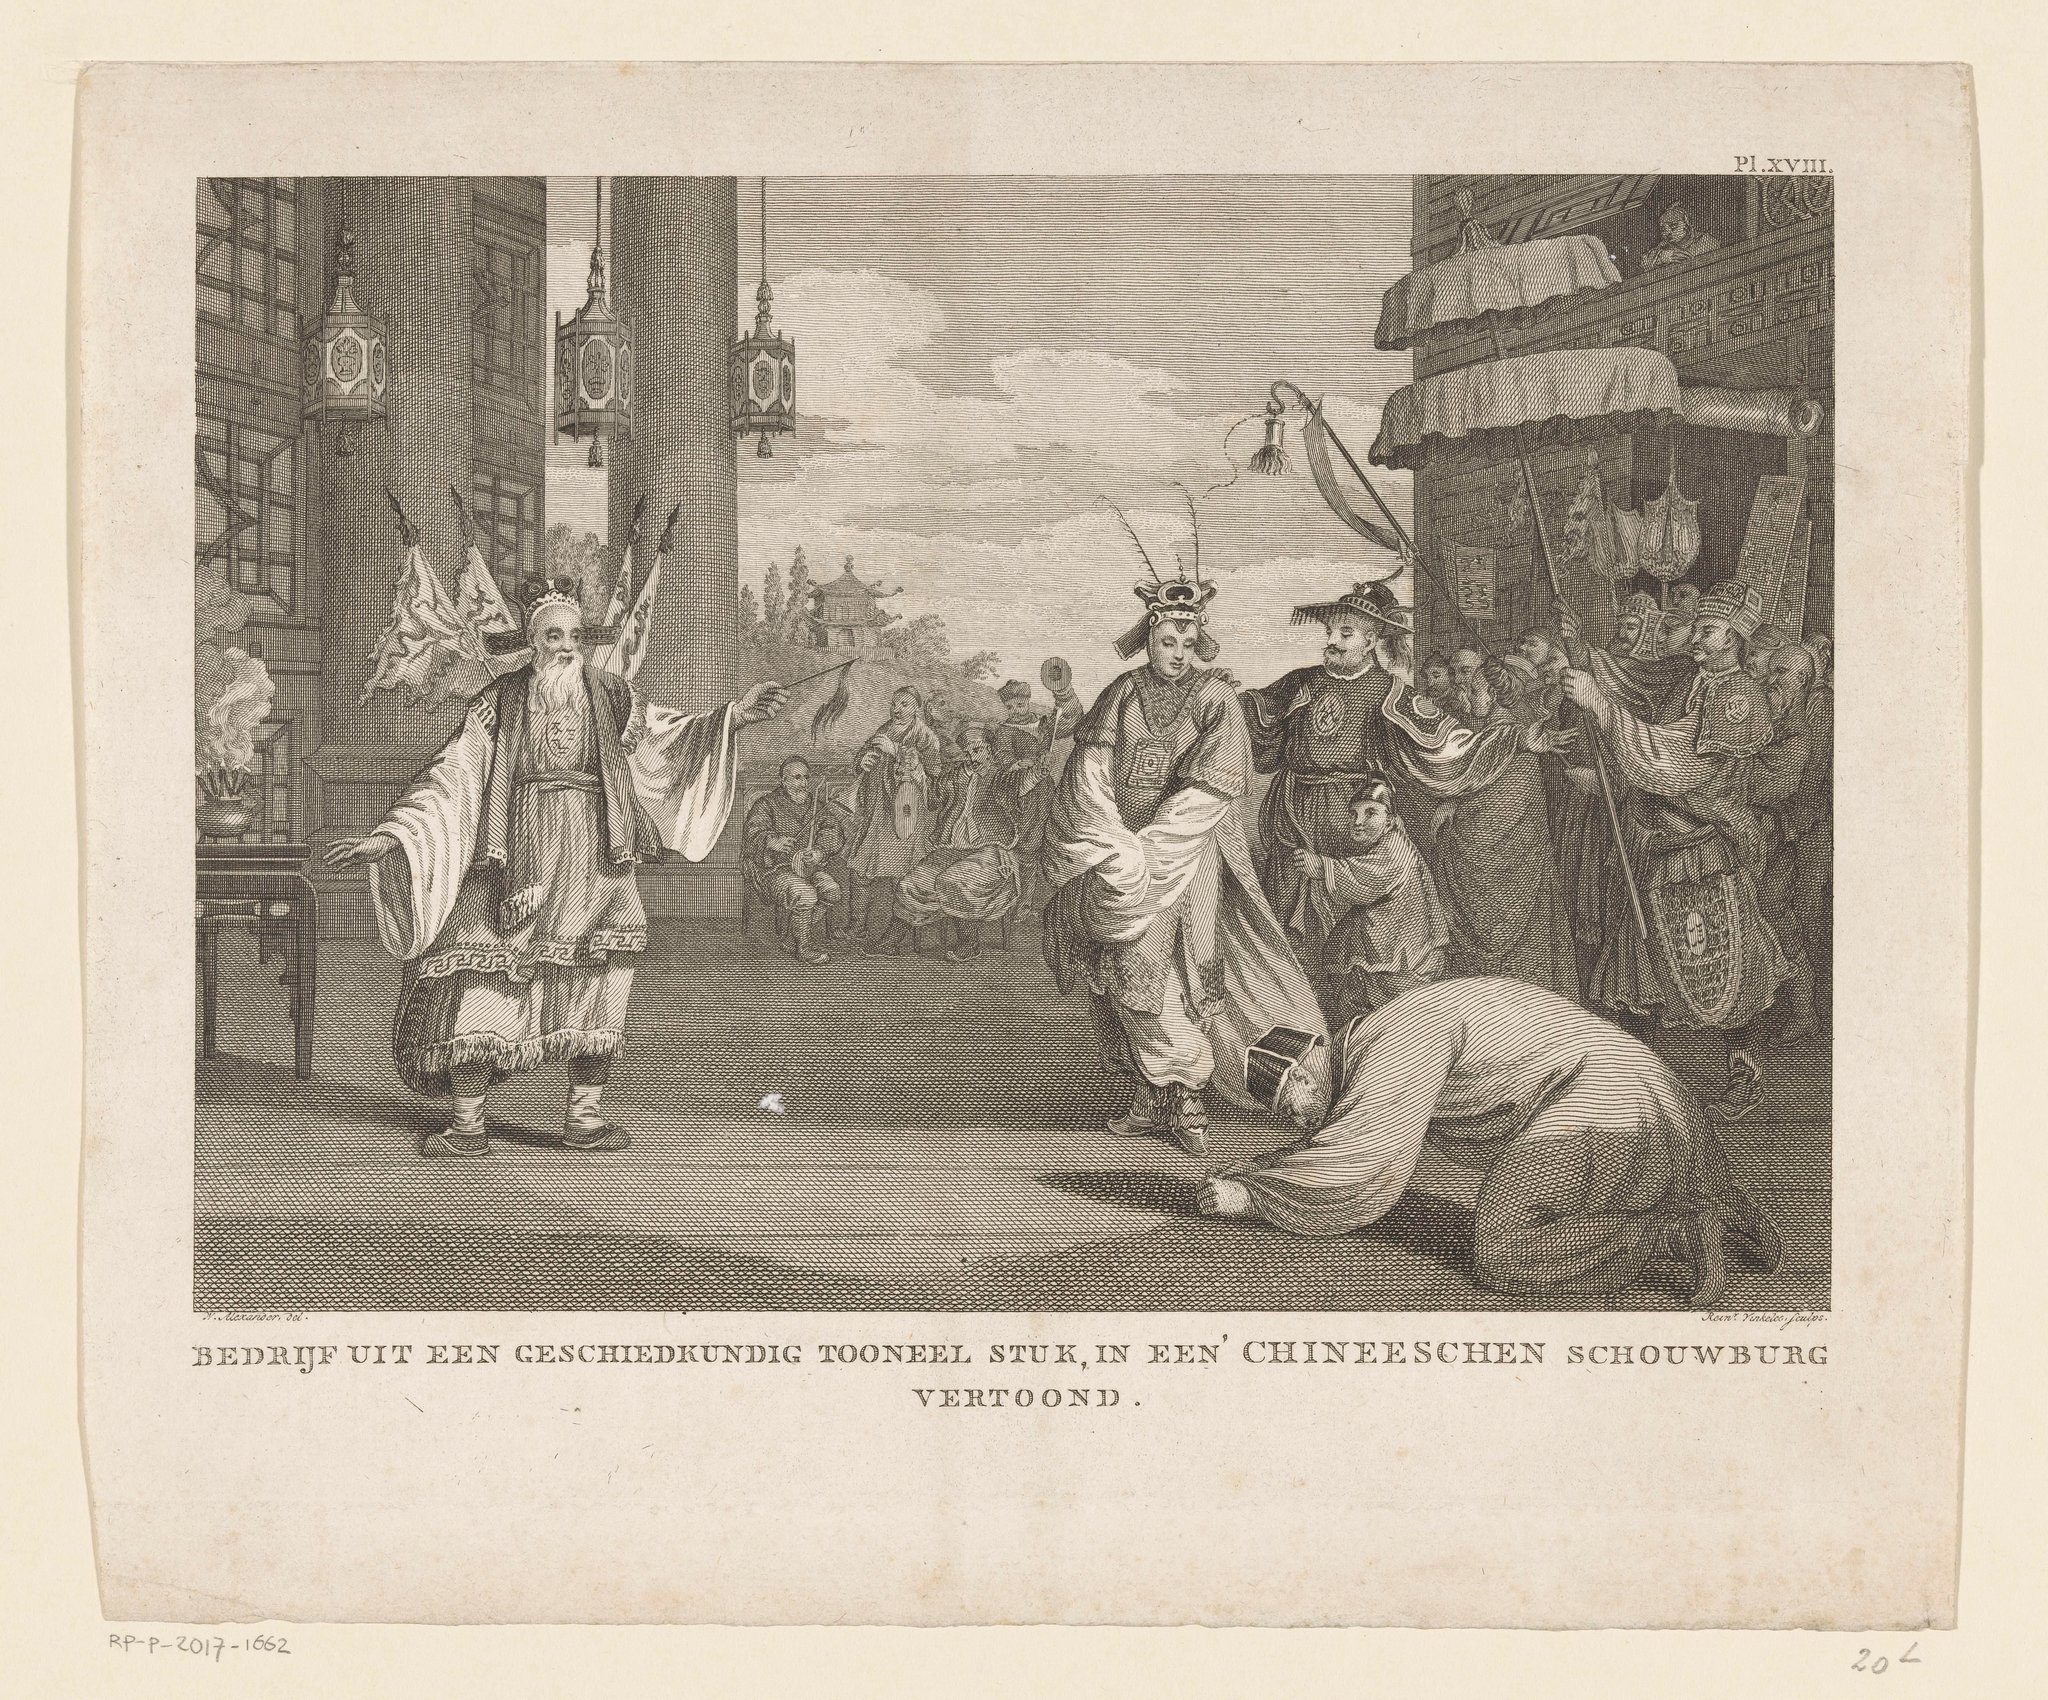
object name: print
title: Bedrijf uit een geschiedkundig tooneel stuk, in een Chineeschen schouwburg vertoond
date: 1777-1816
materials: paper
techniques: engraving, etching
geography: amsterdam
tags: theatre, theatrical performance, theatre (building), lantern, china